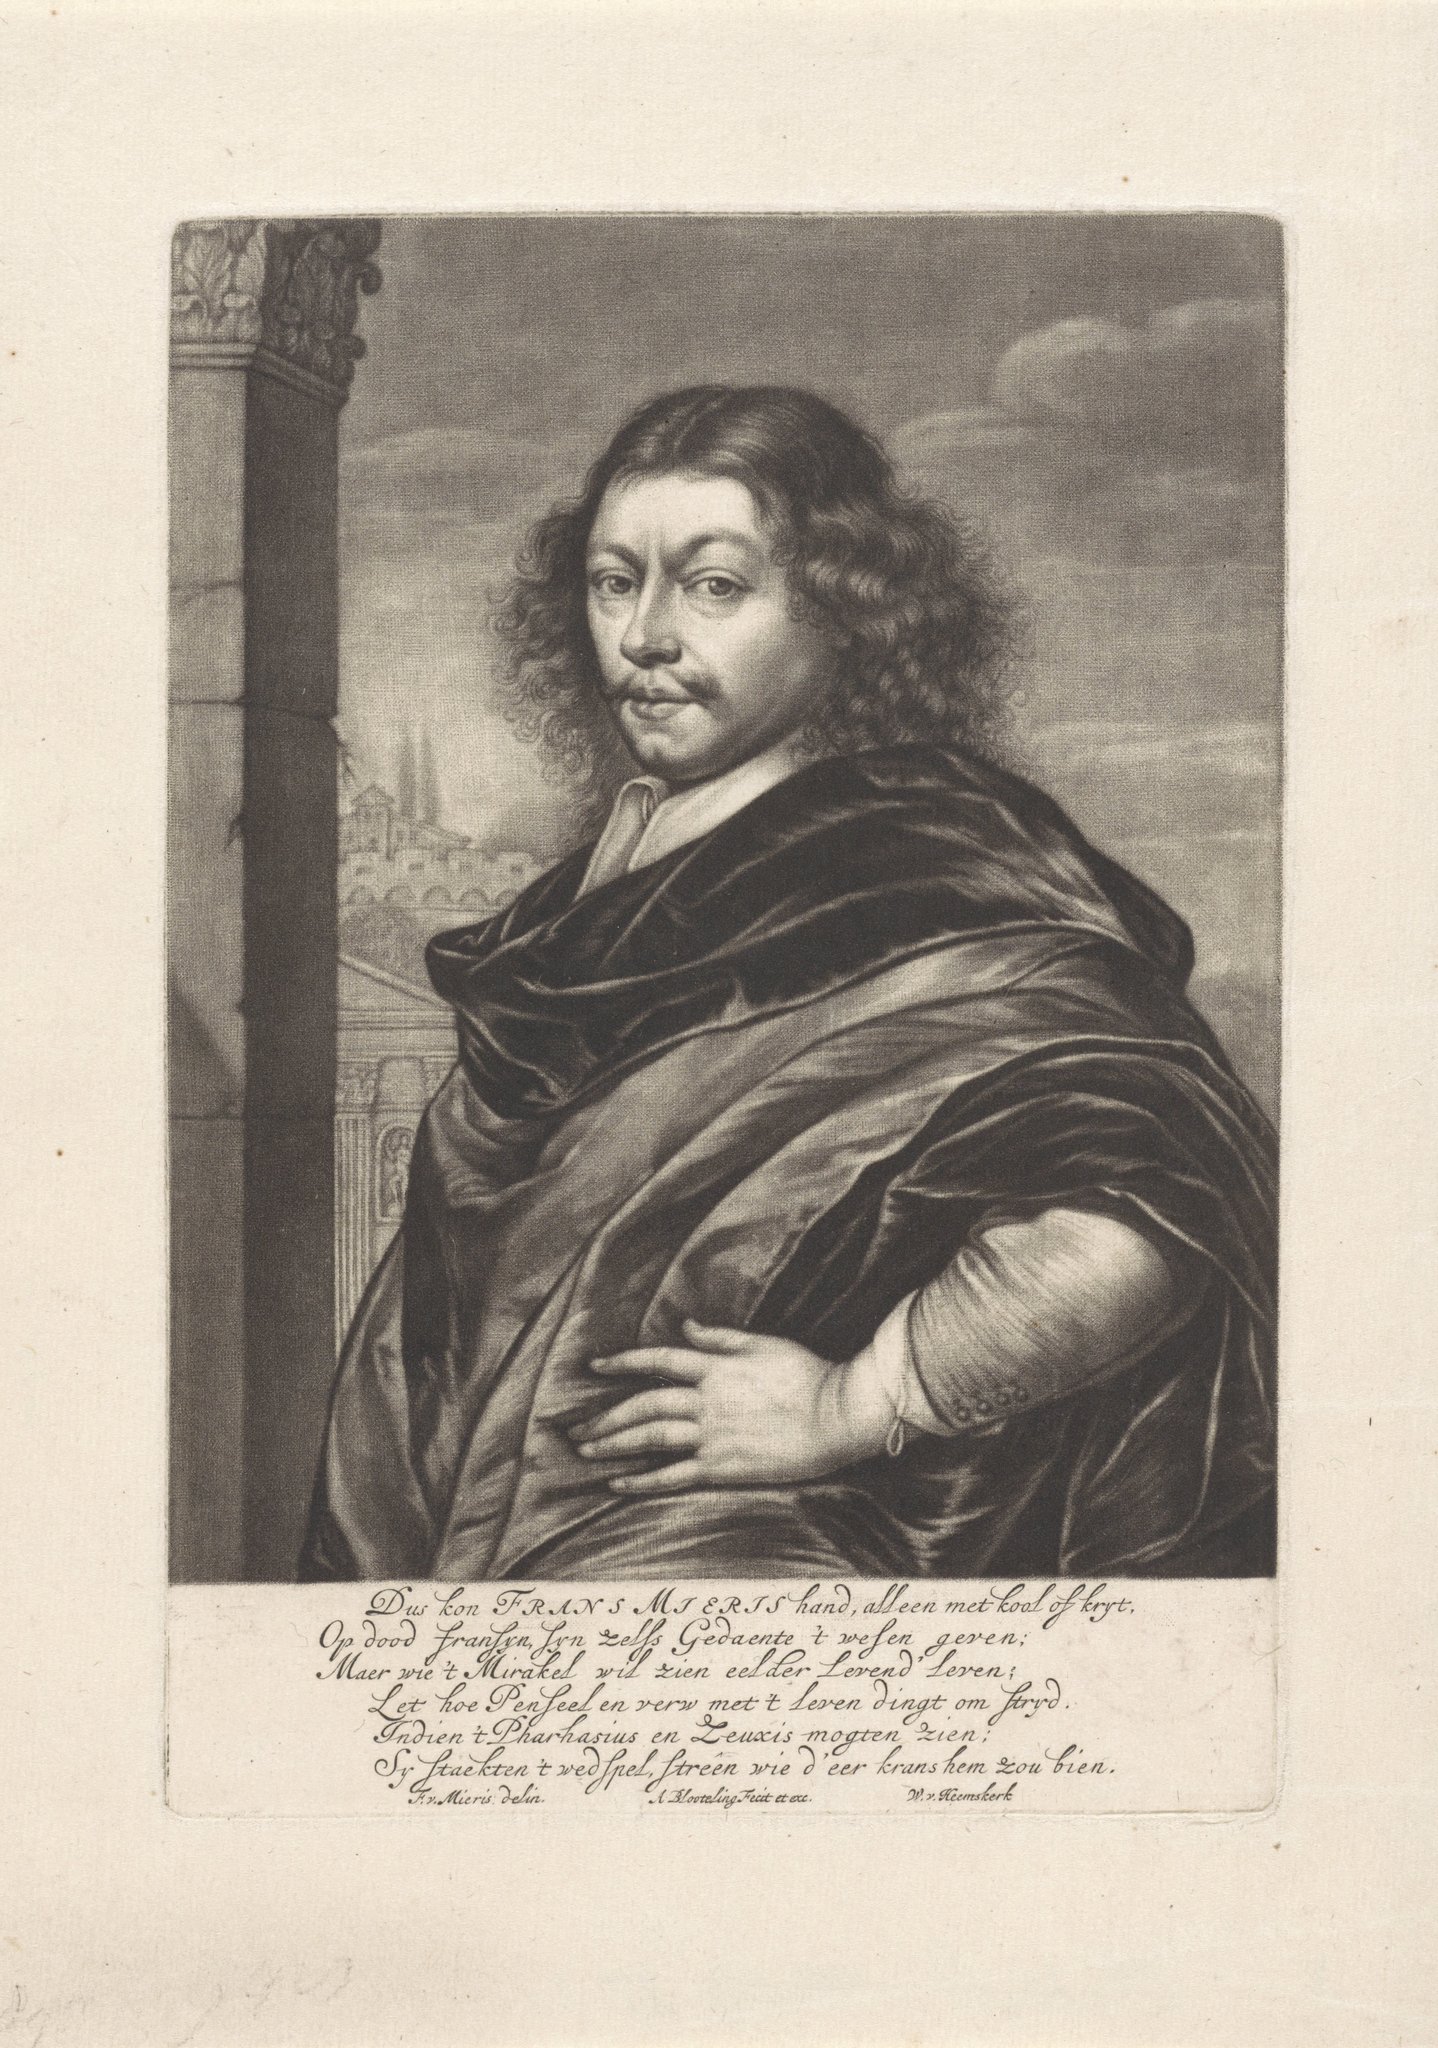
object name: print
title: Portret van Frans van Mieris (I)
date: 1655-1690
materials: paper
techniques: engraving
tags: leiden, draughtsman, frans van mieris (i), portrait, self-portrait of painter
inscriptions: collector's mark: Lugt 240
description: Portret van de schilder Frans van Mieris met de hand in de zij. Op de achtergrond de contouren van een stad.